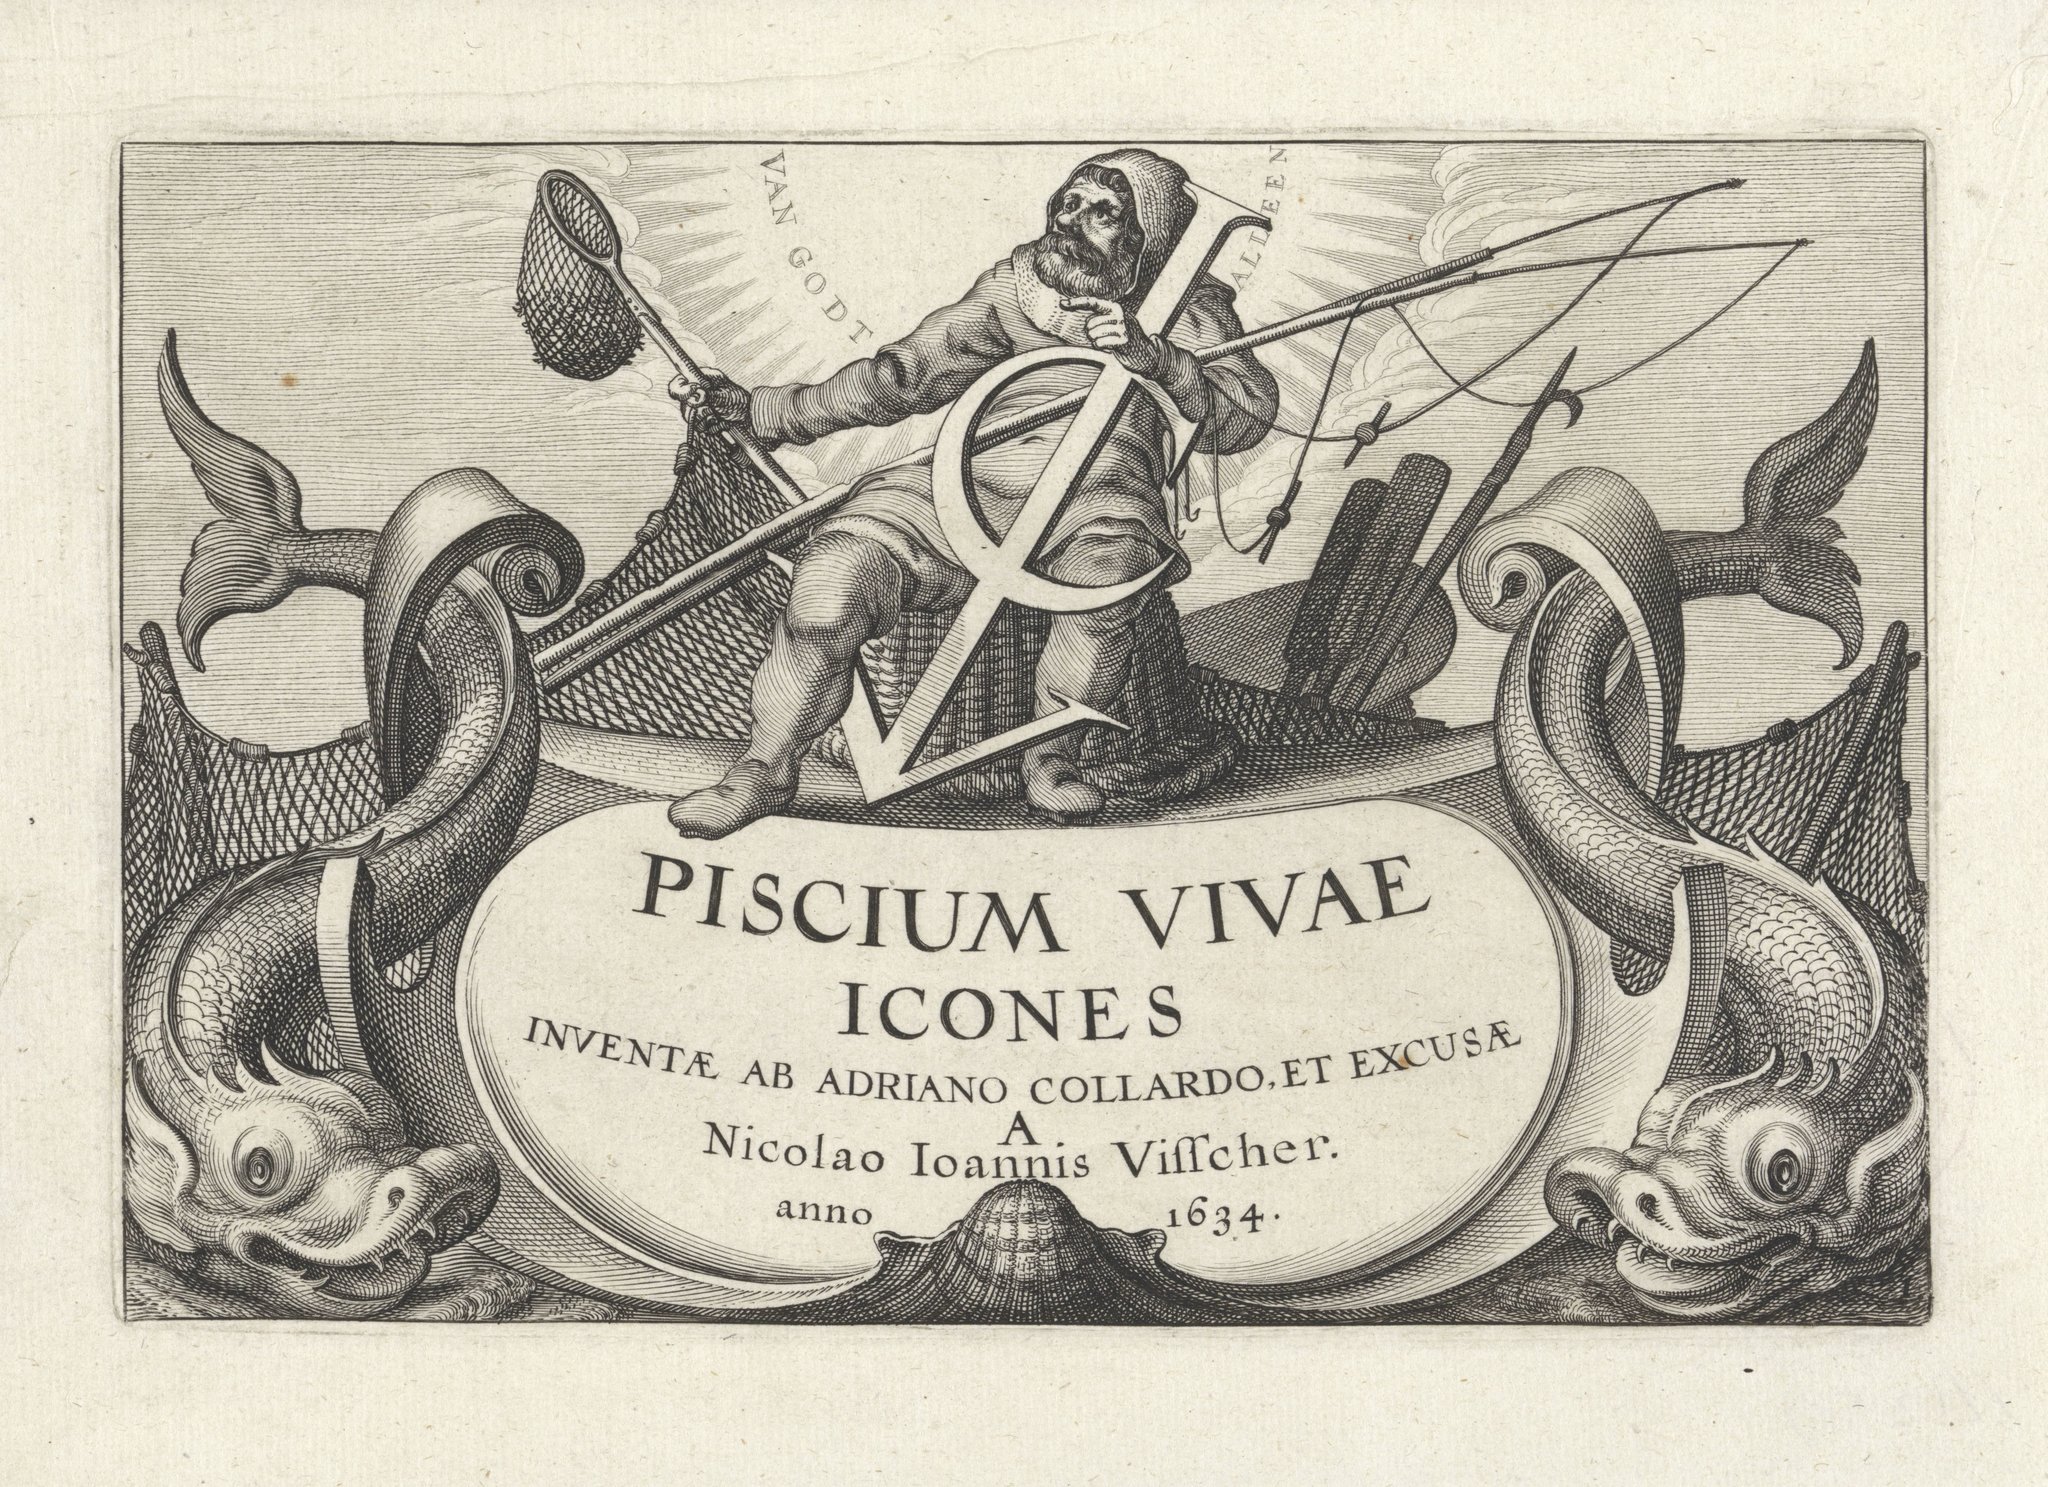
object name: print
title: Titelprent met vissen en een visser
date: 1634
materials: paper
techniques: engraving, etching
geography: amsterdam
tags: fishes, fisherman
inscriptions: collector's mark: Lugt 240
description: Centraal de titel van de prentserie in een cartouche, geflankeerd door twee vissen. Op de titel zit een visser met in zijn armen netten, hengels en de initialen van Claes Jansz. Visscher. Achter hem straalt de zon. Dit is de titelprent van een serie met vissen als onderwerp.